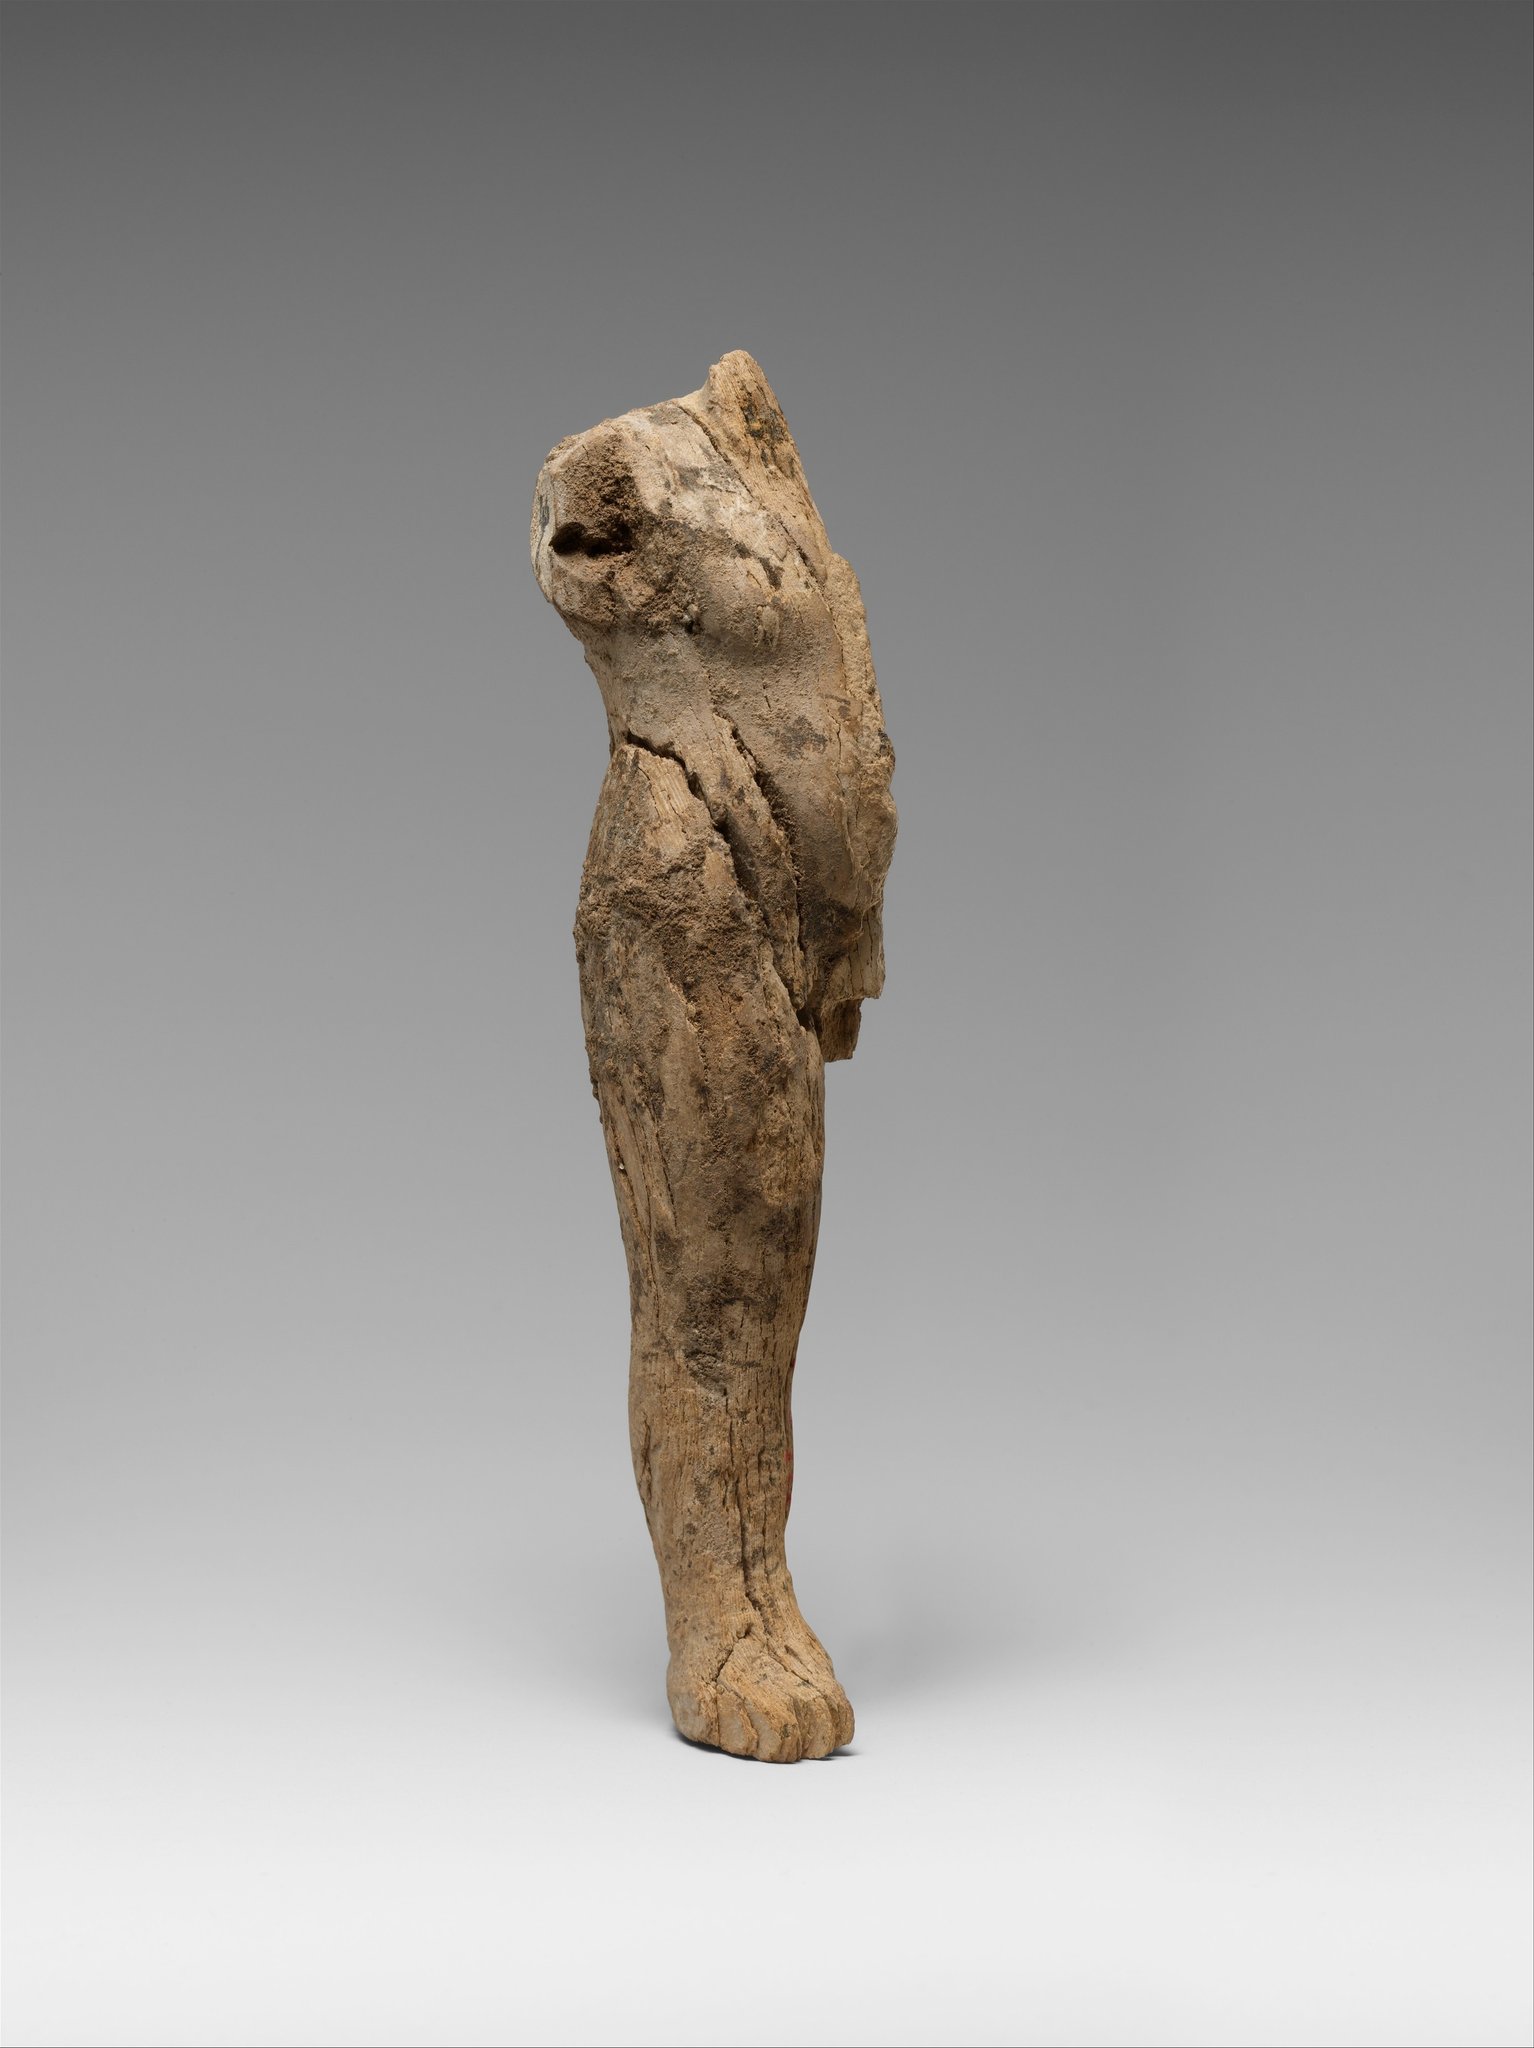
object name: statuette, young boy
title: Partial statuette probably depicting a young boy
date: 3100-2650 BCE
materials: ivory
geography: egypt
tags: boys